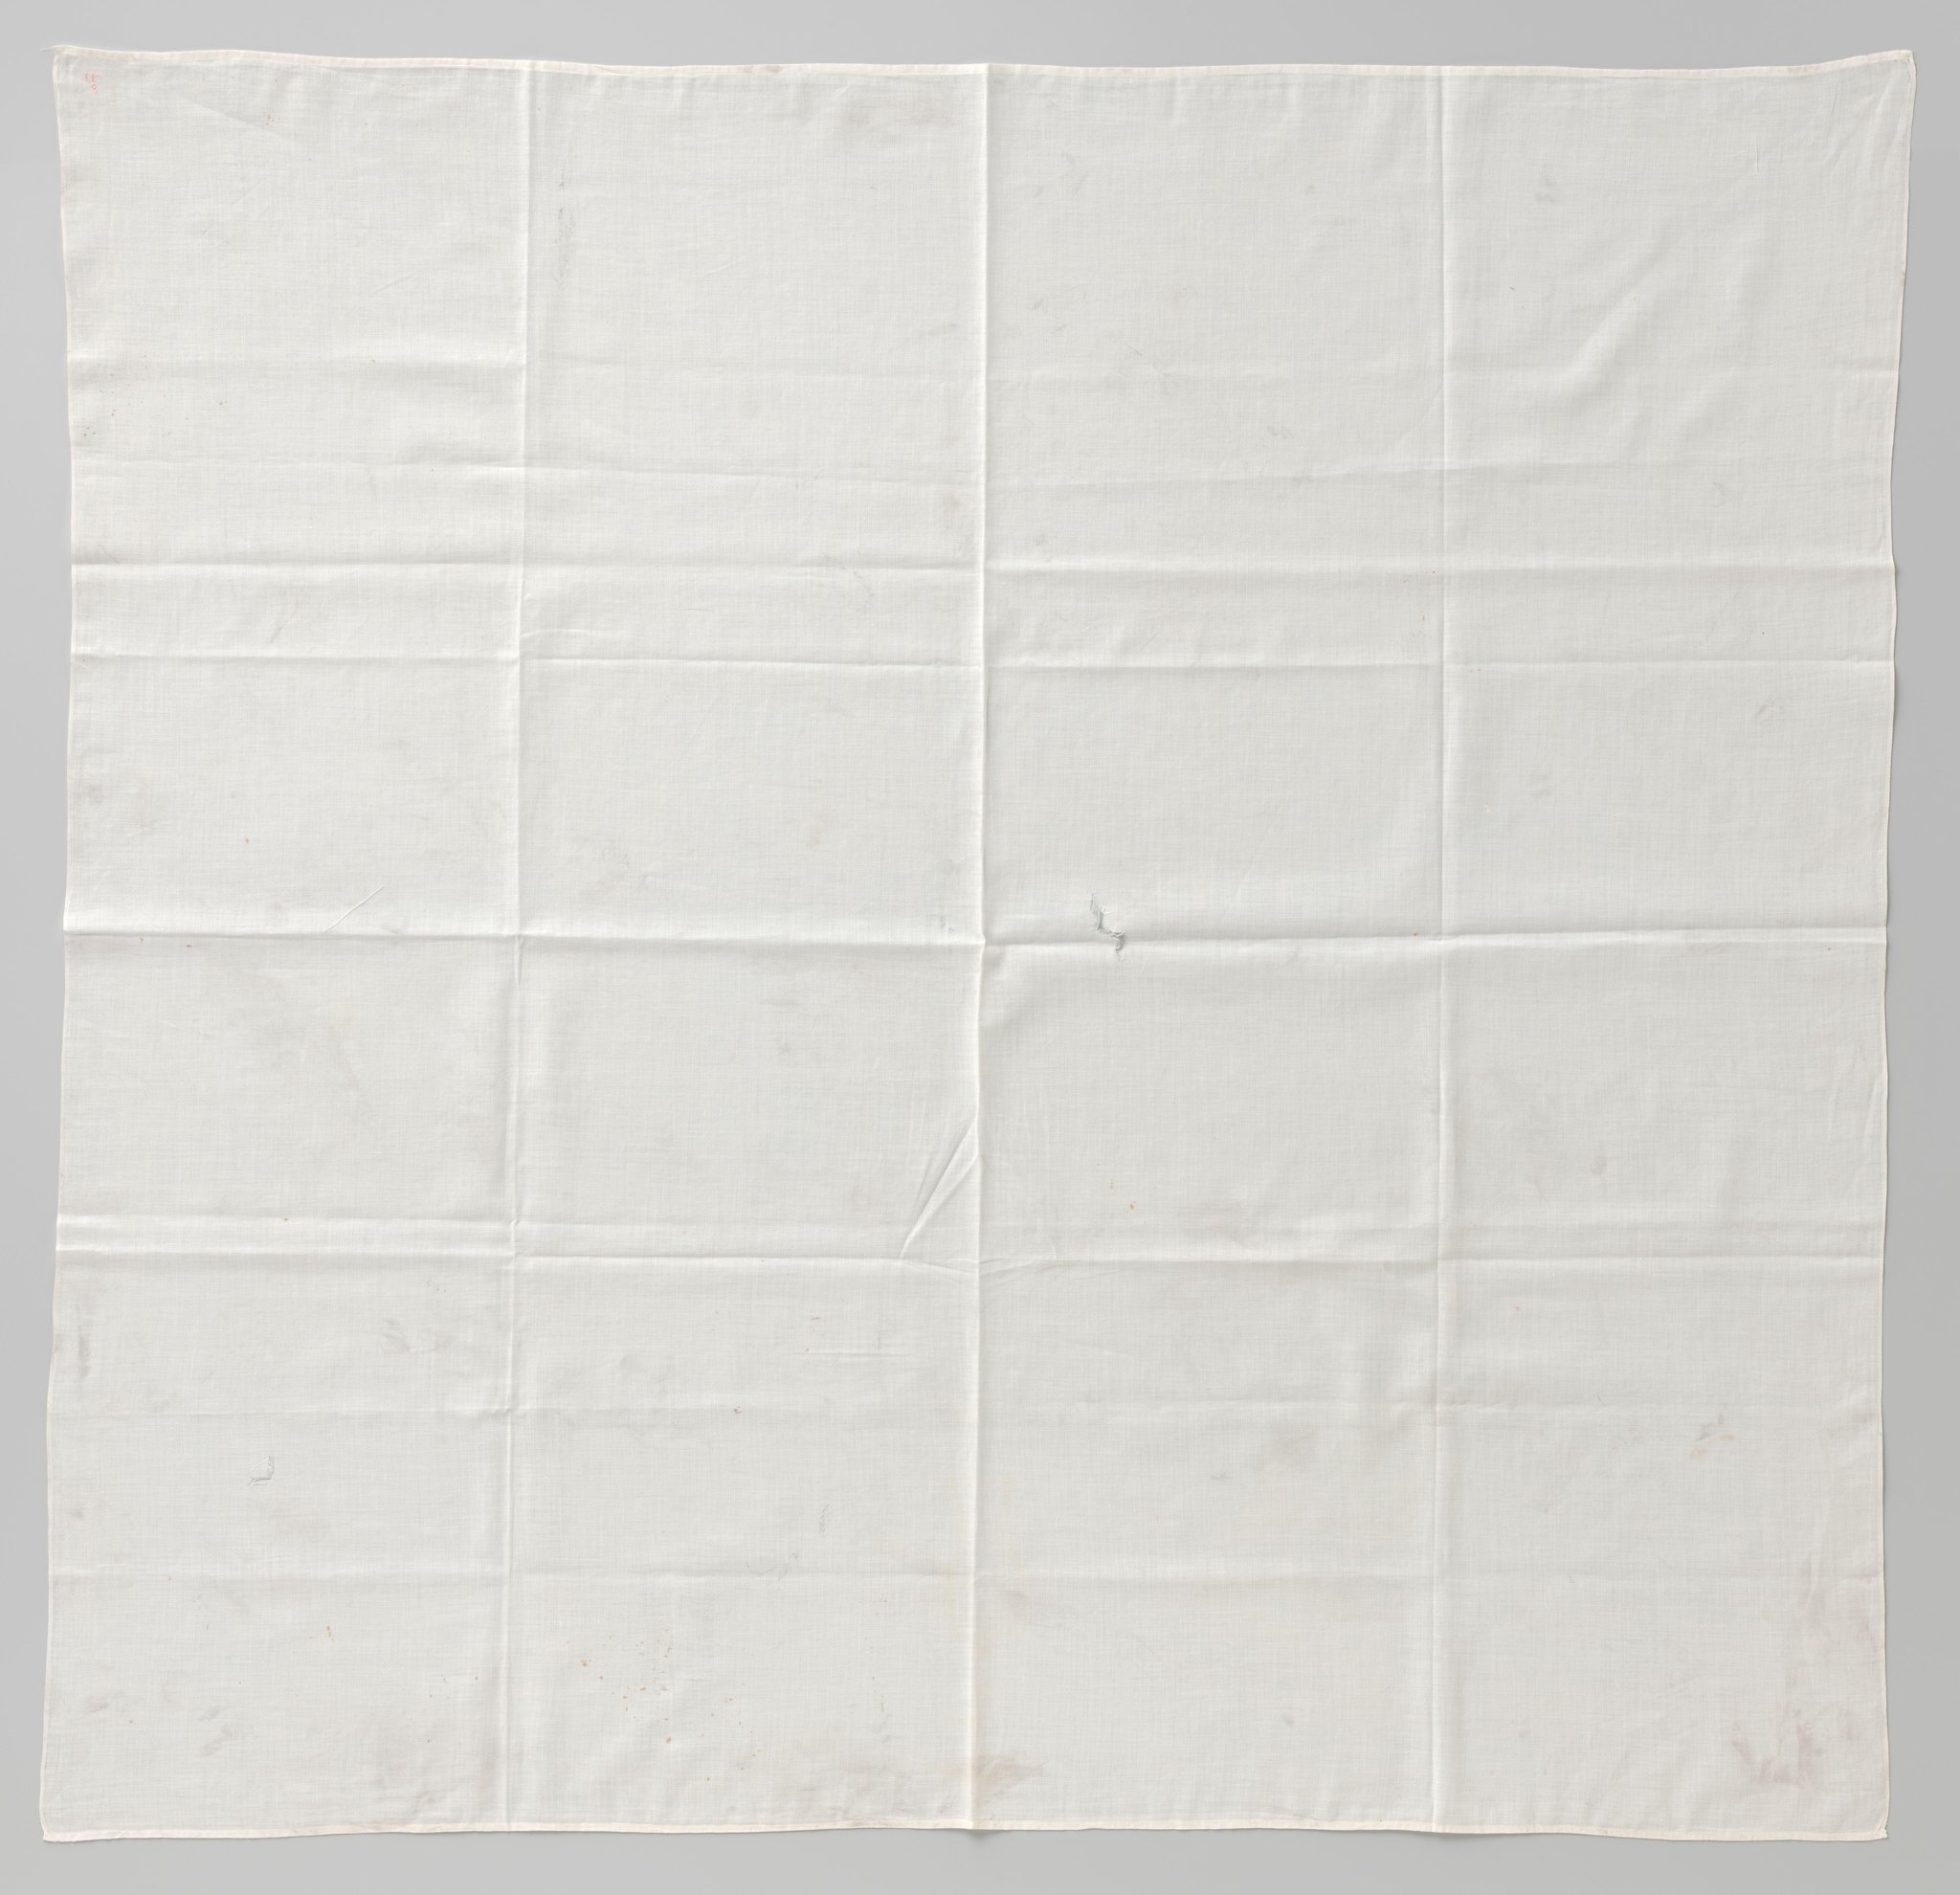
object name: cloth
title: Doek van wit katoen of linnen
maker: Anonymous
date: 1700-1920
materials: cotton, linen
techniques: cross stitching, weave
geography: western europe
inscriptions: : ‘IM / 8’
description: Doek van wit katoen of linnen in platbinding. Tweemaal zelfkant en tweemaal kanten omgezoomd. Gemerkt: IM 8 in rode kruissteek.